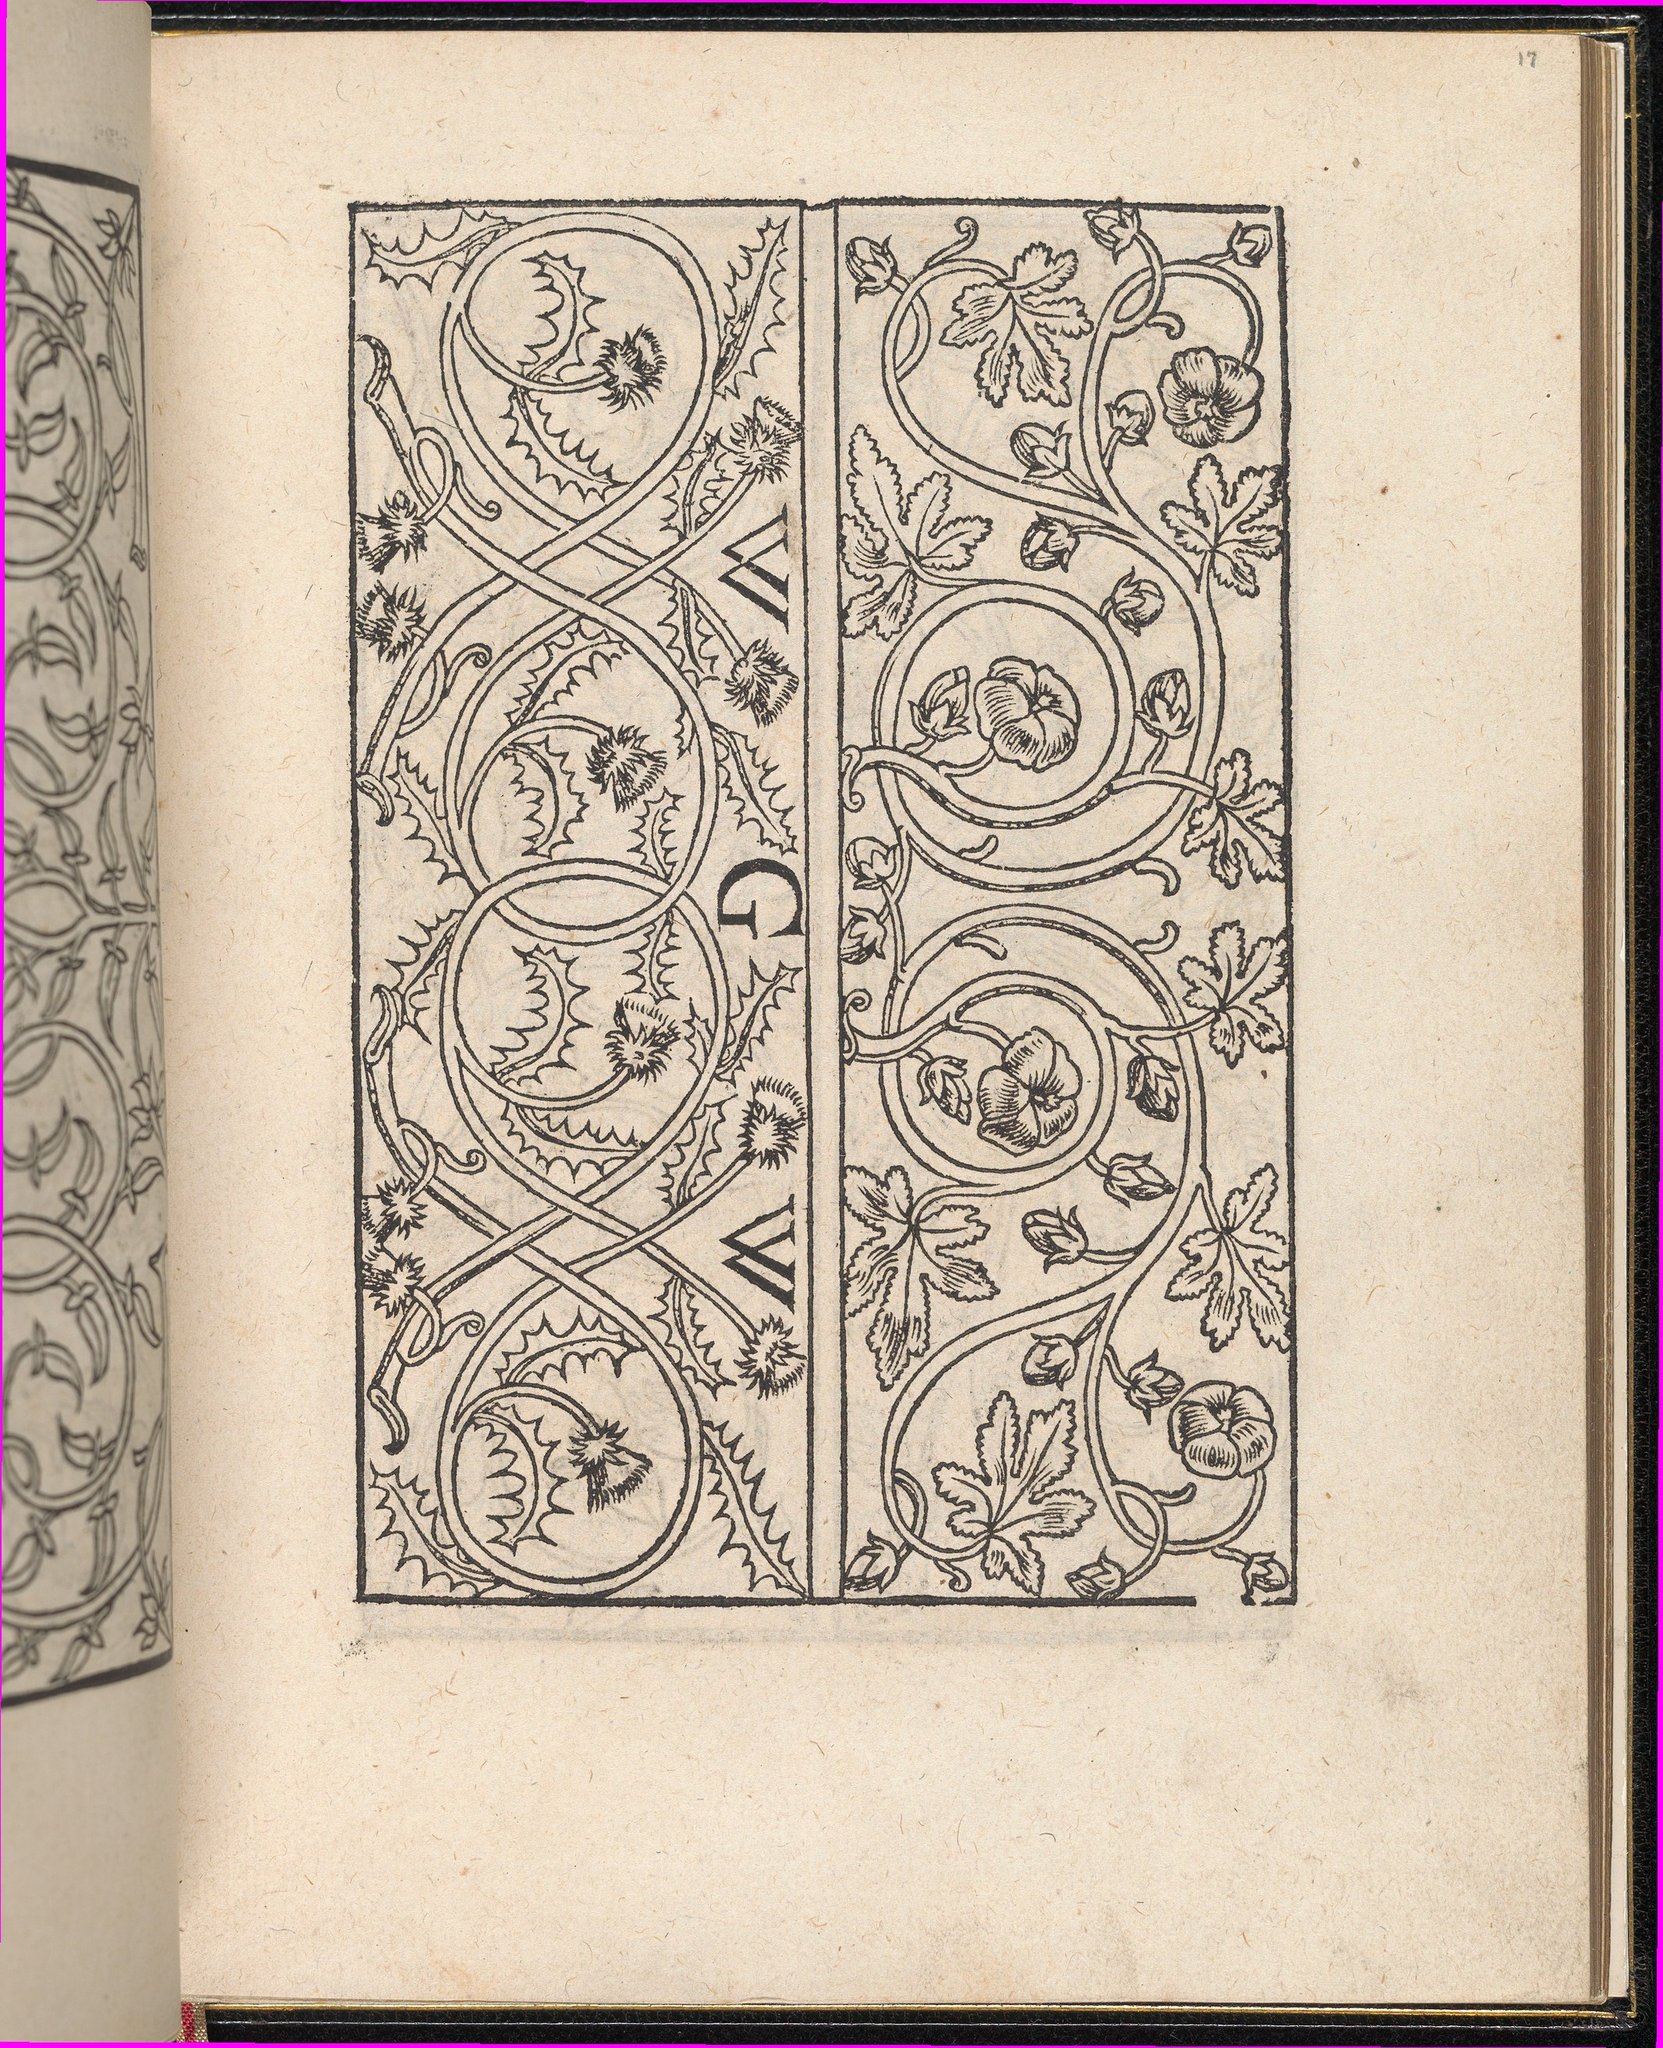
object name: book print ornament architecture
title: Page from Ein new kunstlich Modelbuch...(Page 17r)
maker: peter quentel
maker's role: publisher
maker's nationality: german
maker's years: 1500-1550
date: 1544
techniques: woodcut